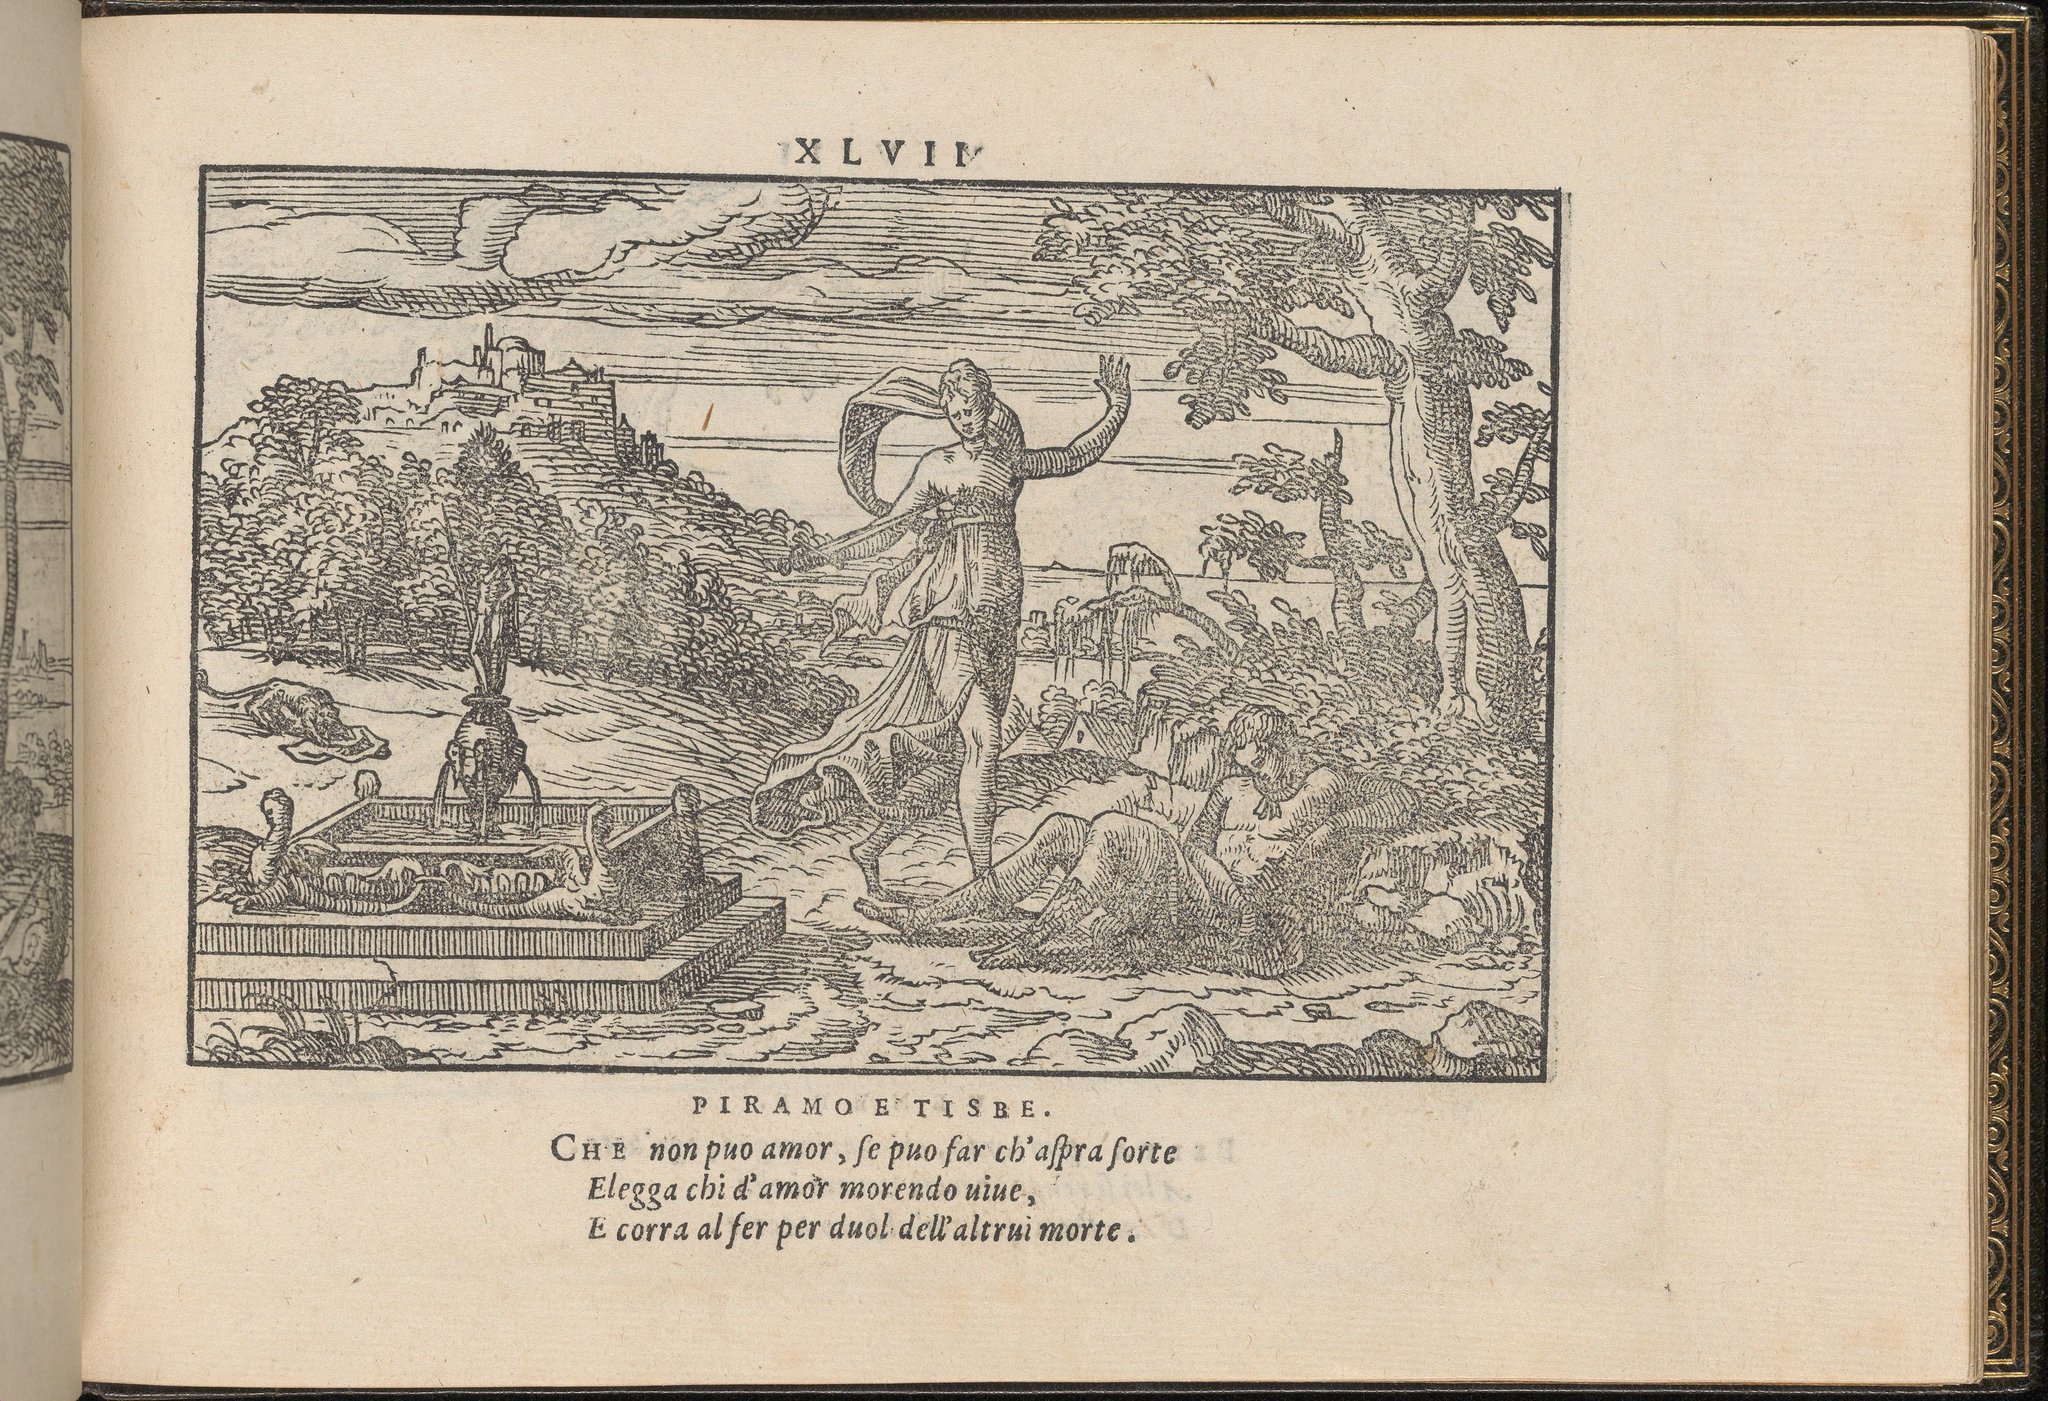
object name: book print ornament architecture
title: La Vera Perfettione del Disegno di varie sorti di recami, page 24 (recto)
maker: giovanni ostaus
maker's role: publisher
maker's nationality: italian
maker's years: 1507-1607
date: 1567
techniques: woodcut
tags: swords,men,lovers,women